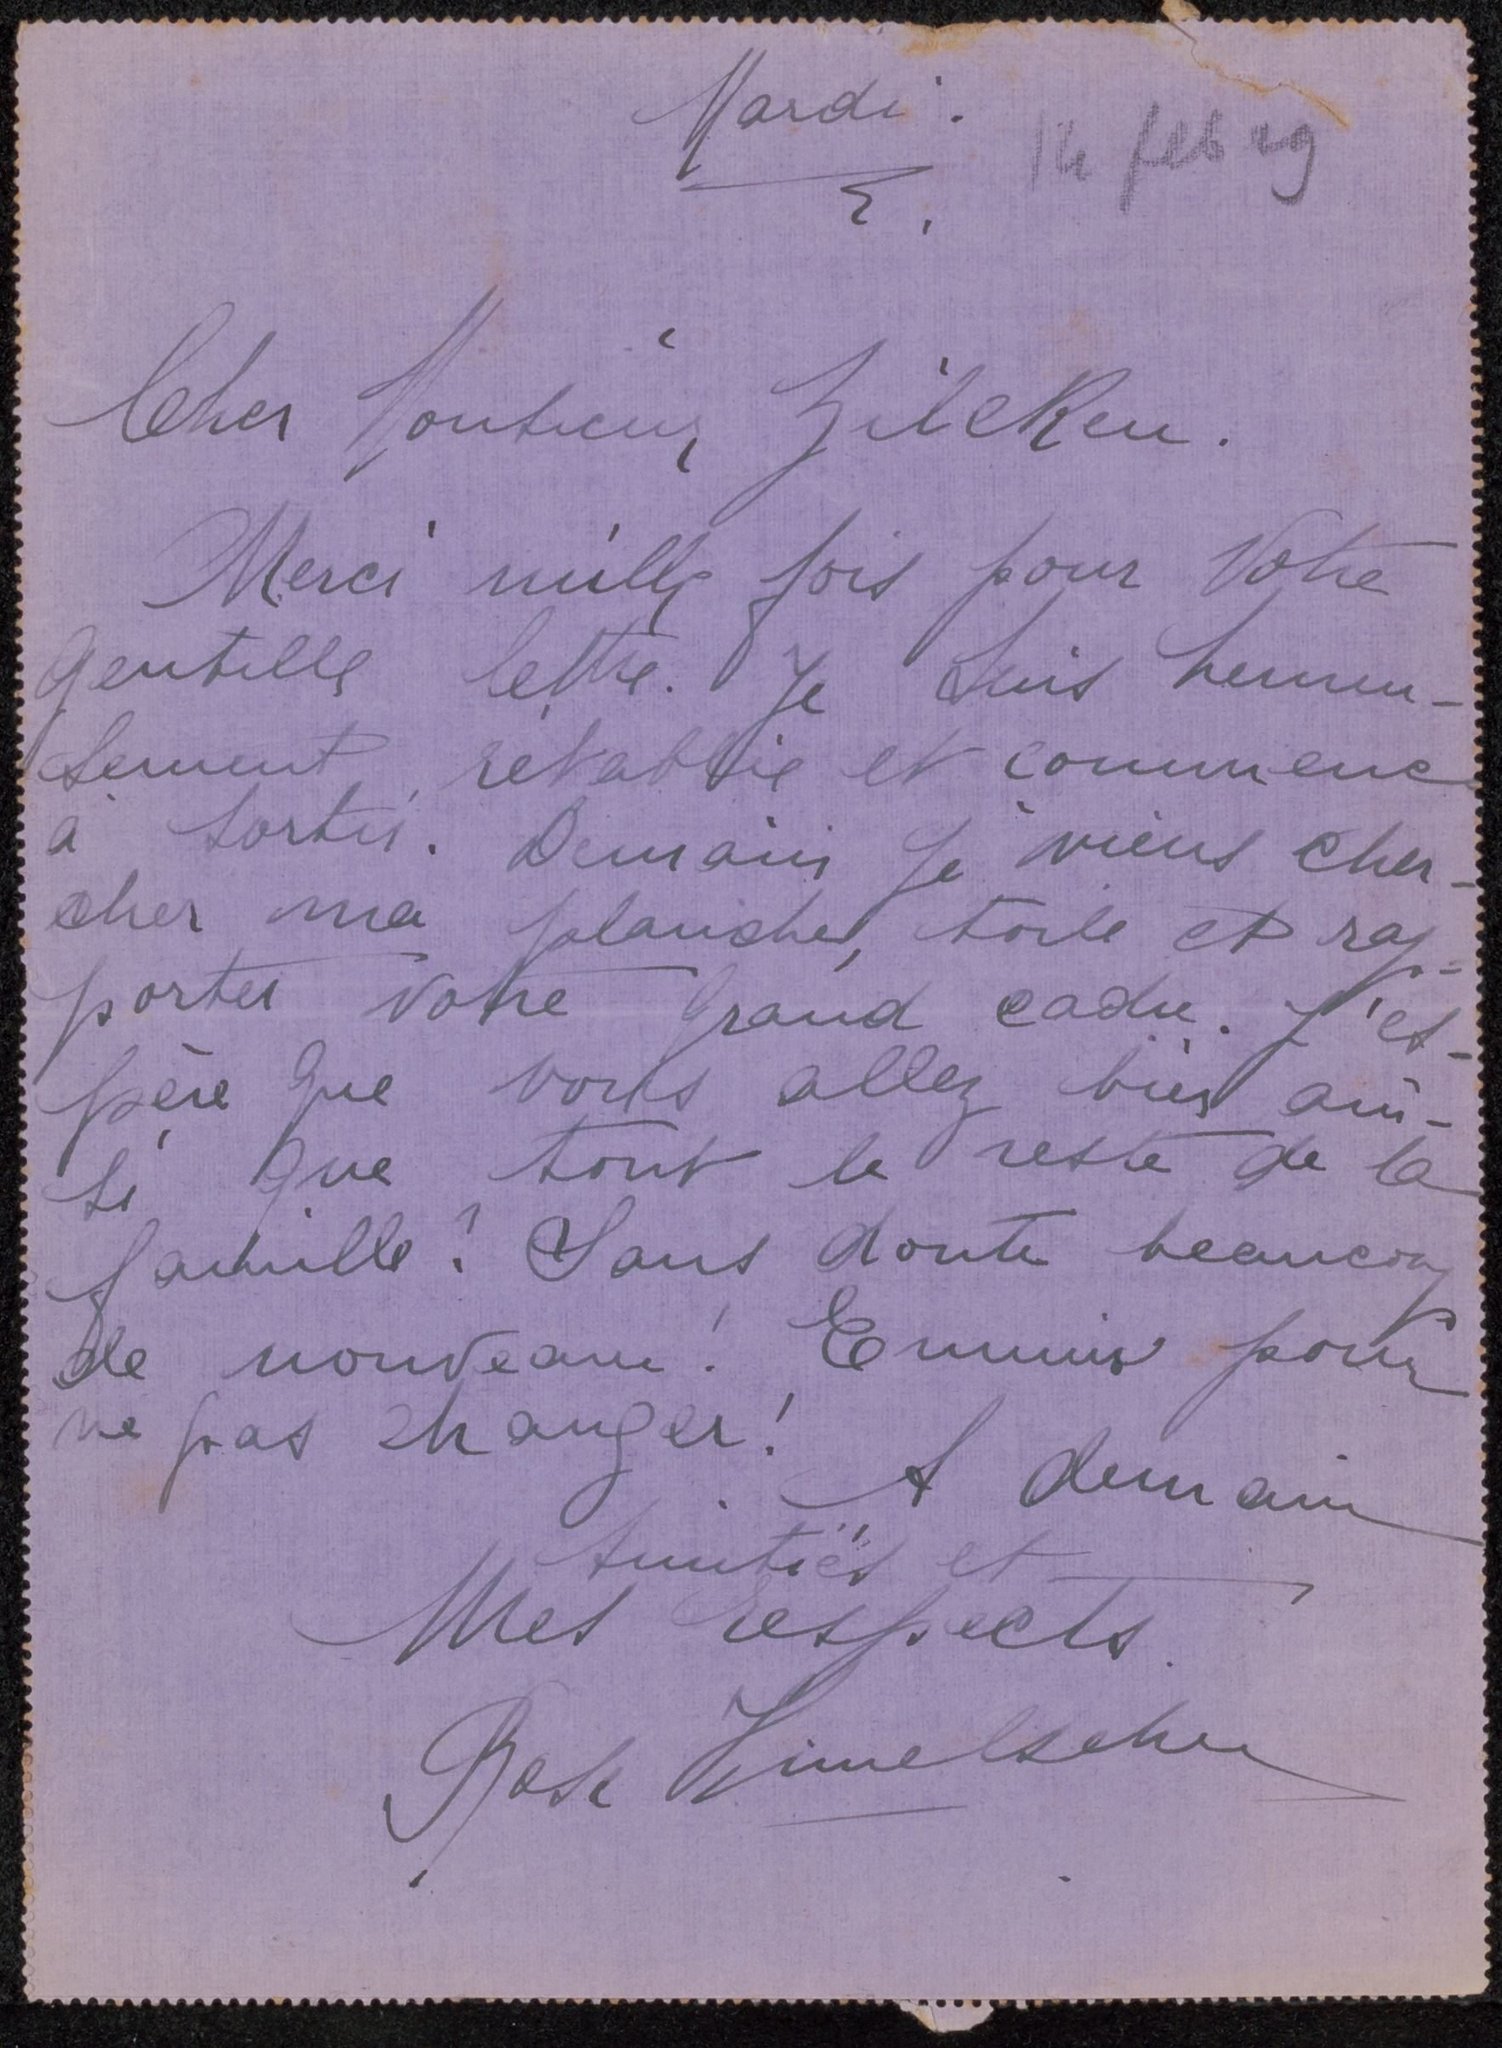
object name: letter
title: Brief aan Philip Zilcken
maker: rose imel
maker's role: draughtsman, painter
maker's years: 1901-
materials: ink, paper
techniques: pen, writing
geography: scheveningen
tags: the hague, painter, draughtsman, philip zilcken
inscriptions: collector's mark: ‘RPK’